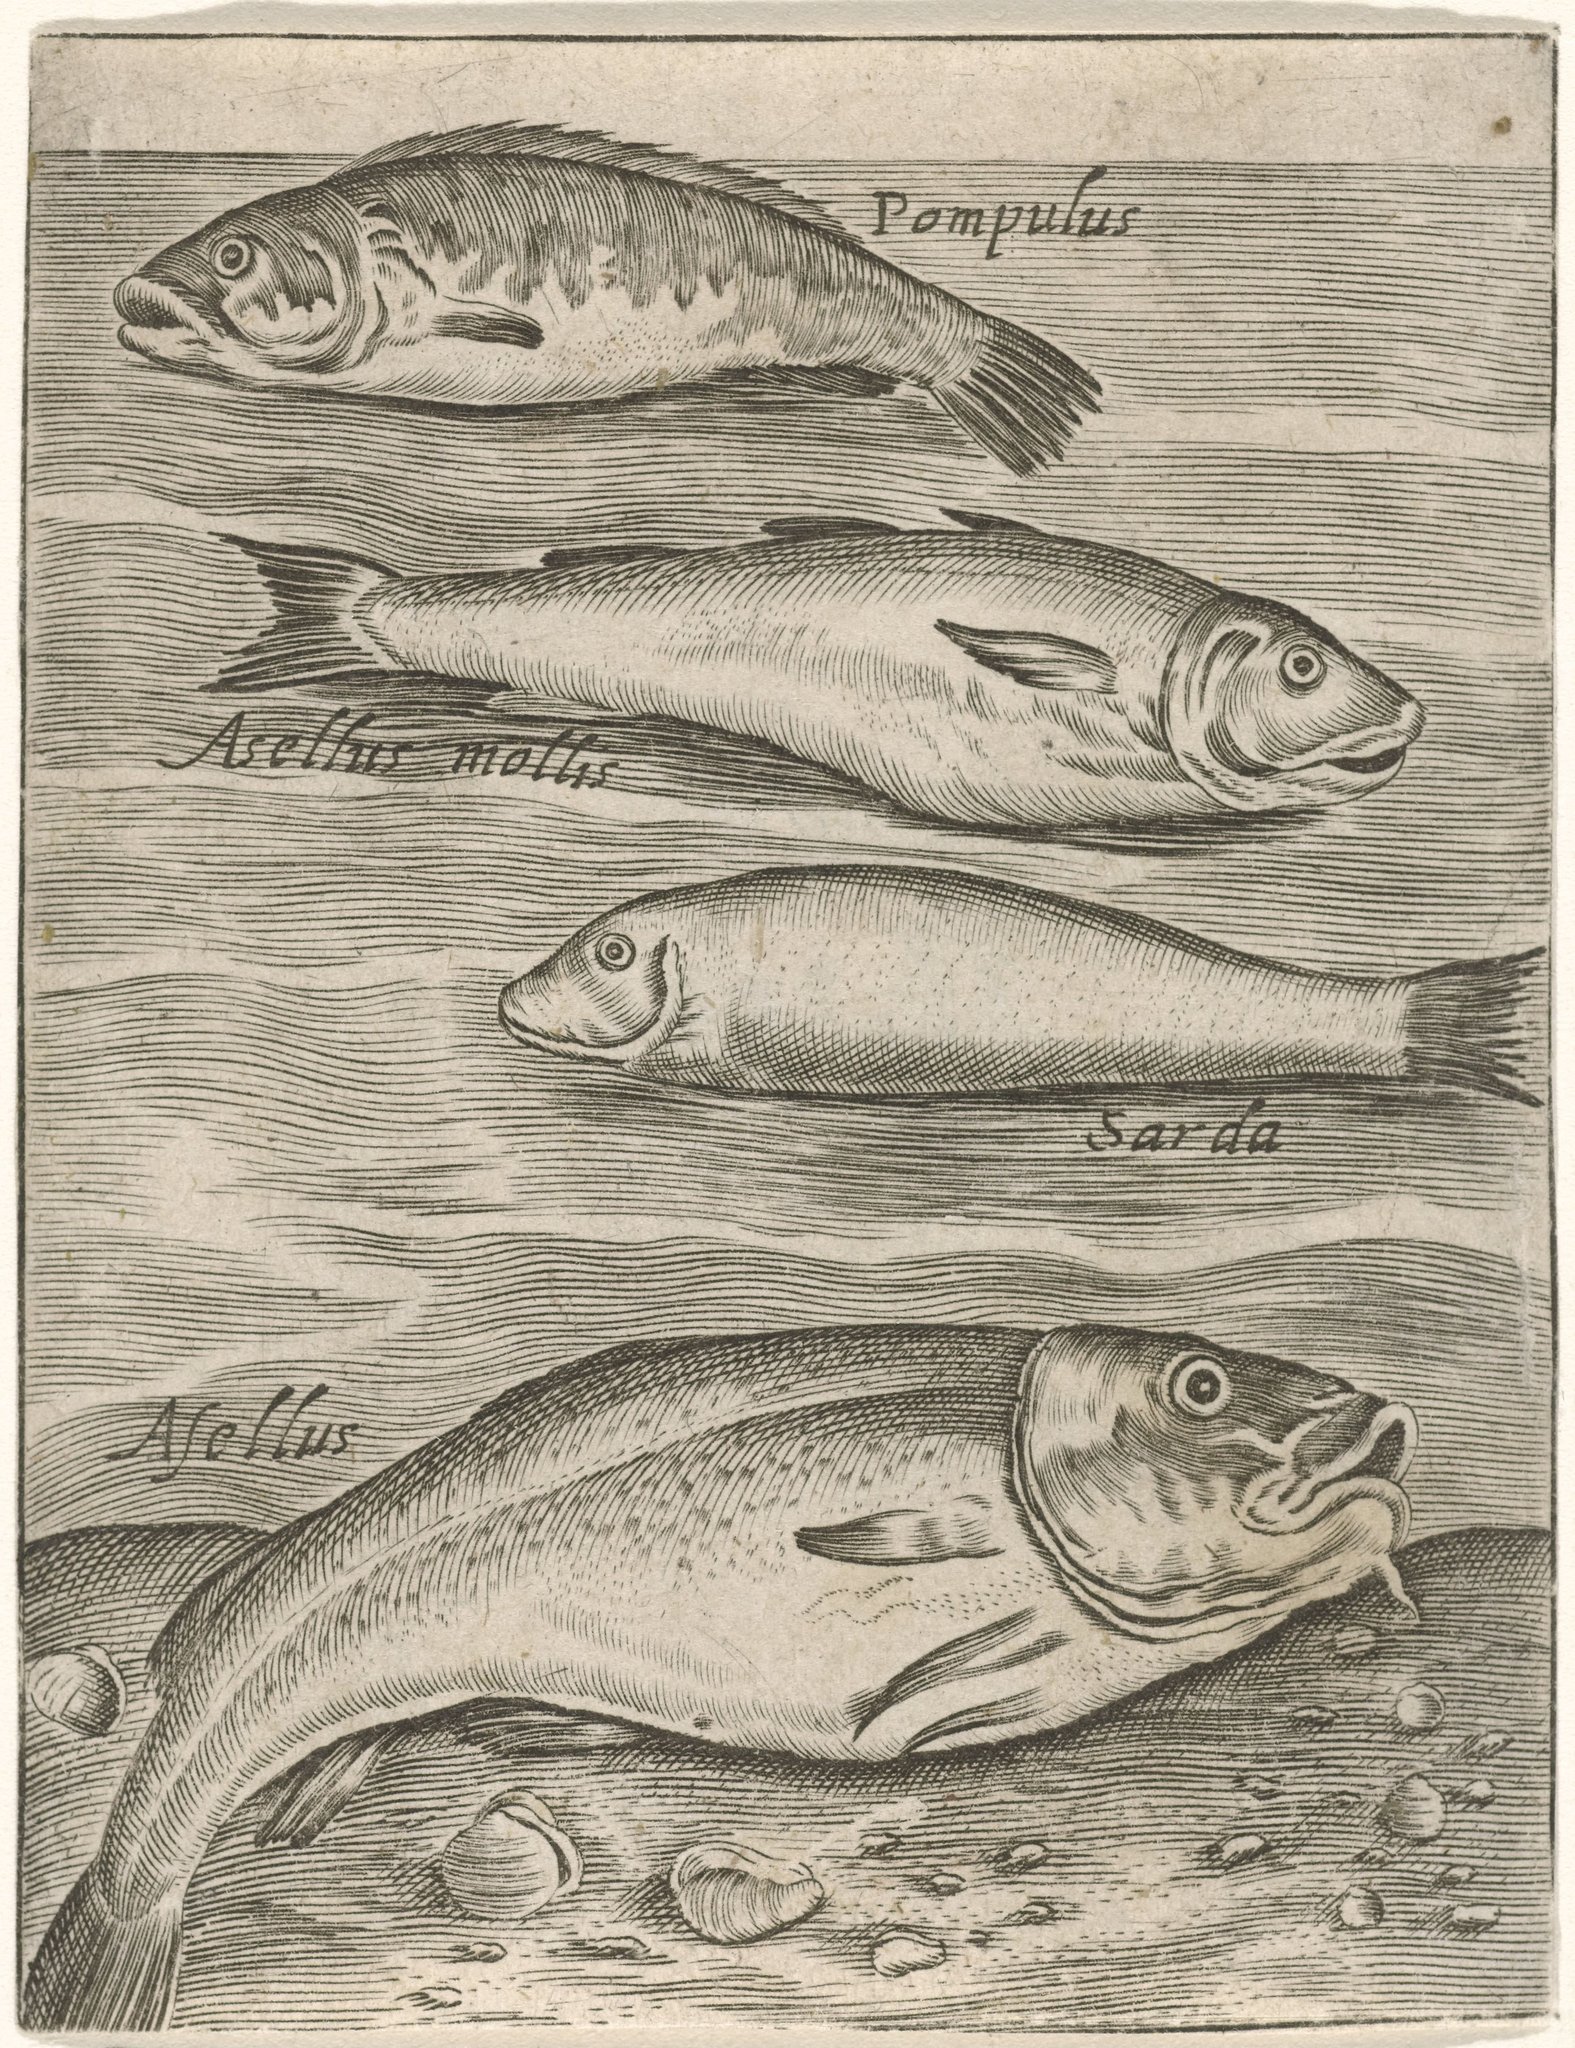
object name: print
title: Piscium vivae icones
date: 1574-1687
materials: paper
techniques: engraving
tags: bony fishes: asellus mollis, bony fishes: asellus, bony fishes: pompulus, bony fishes: sarda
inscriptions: collector's mark: Lugt 2228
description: Studieblad met vier vissen en hun Latijnse naam.